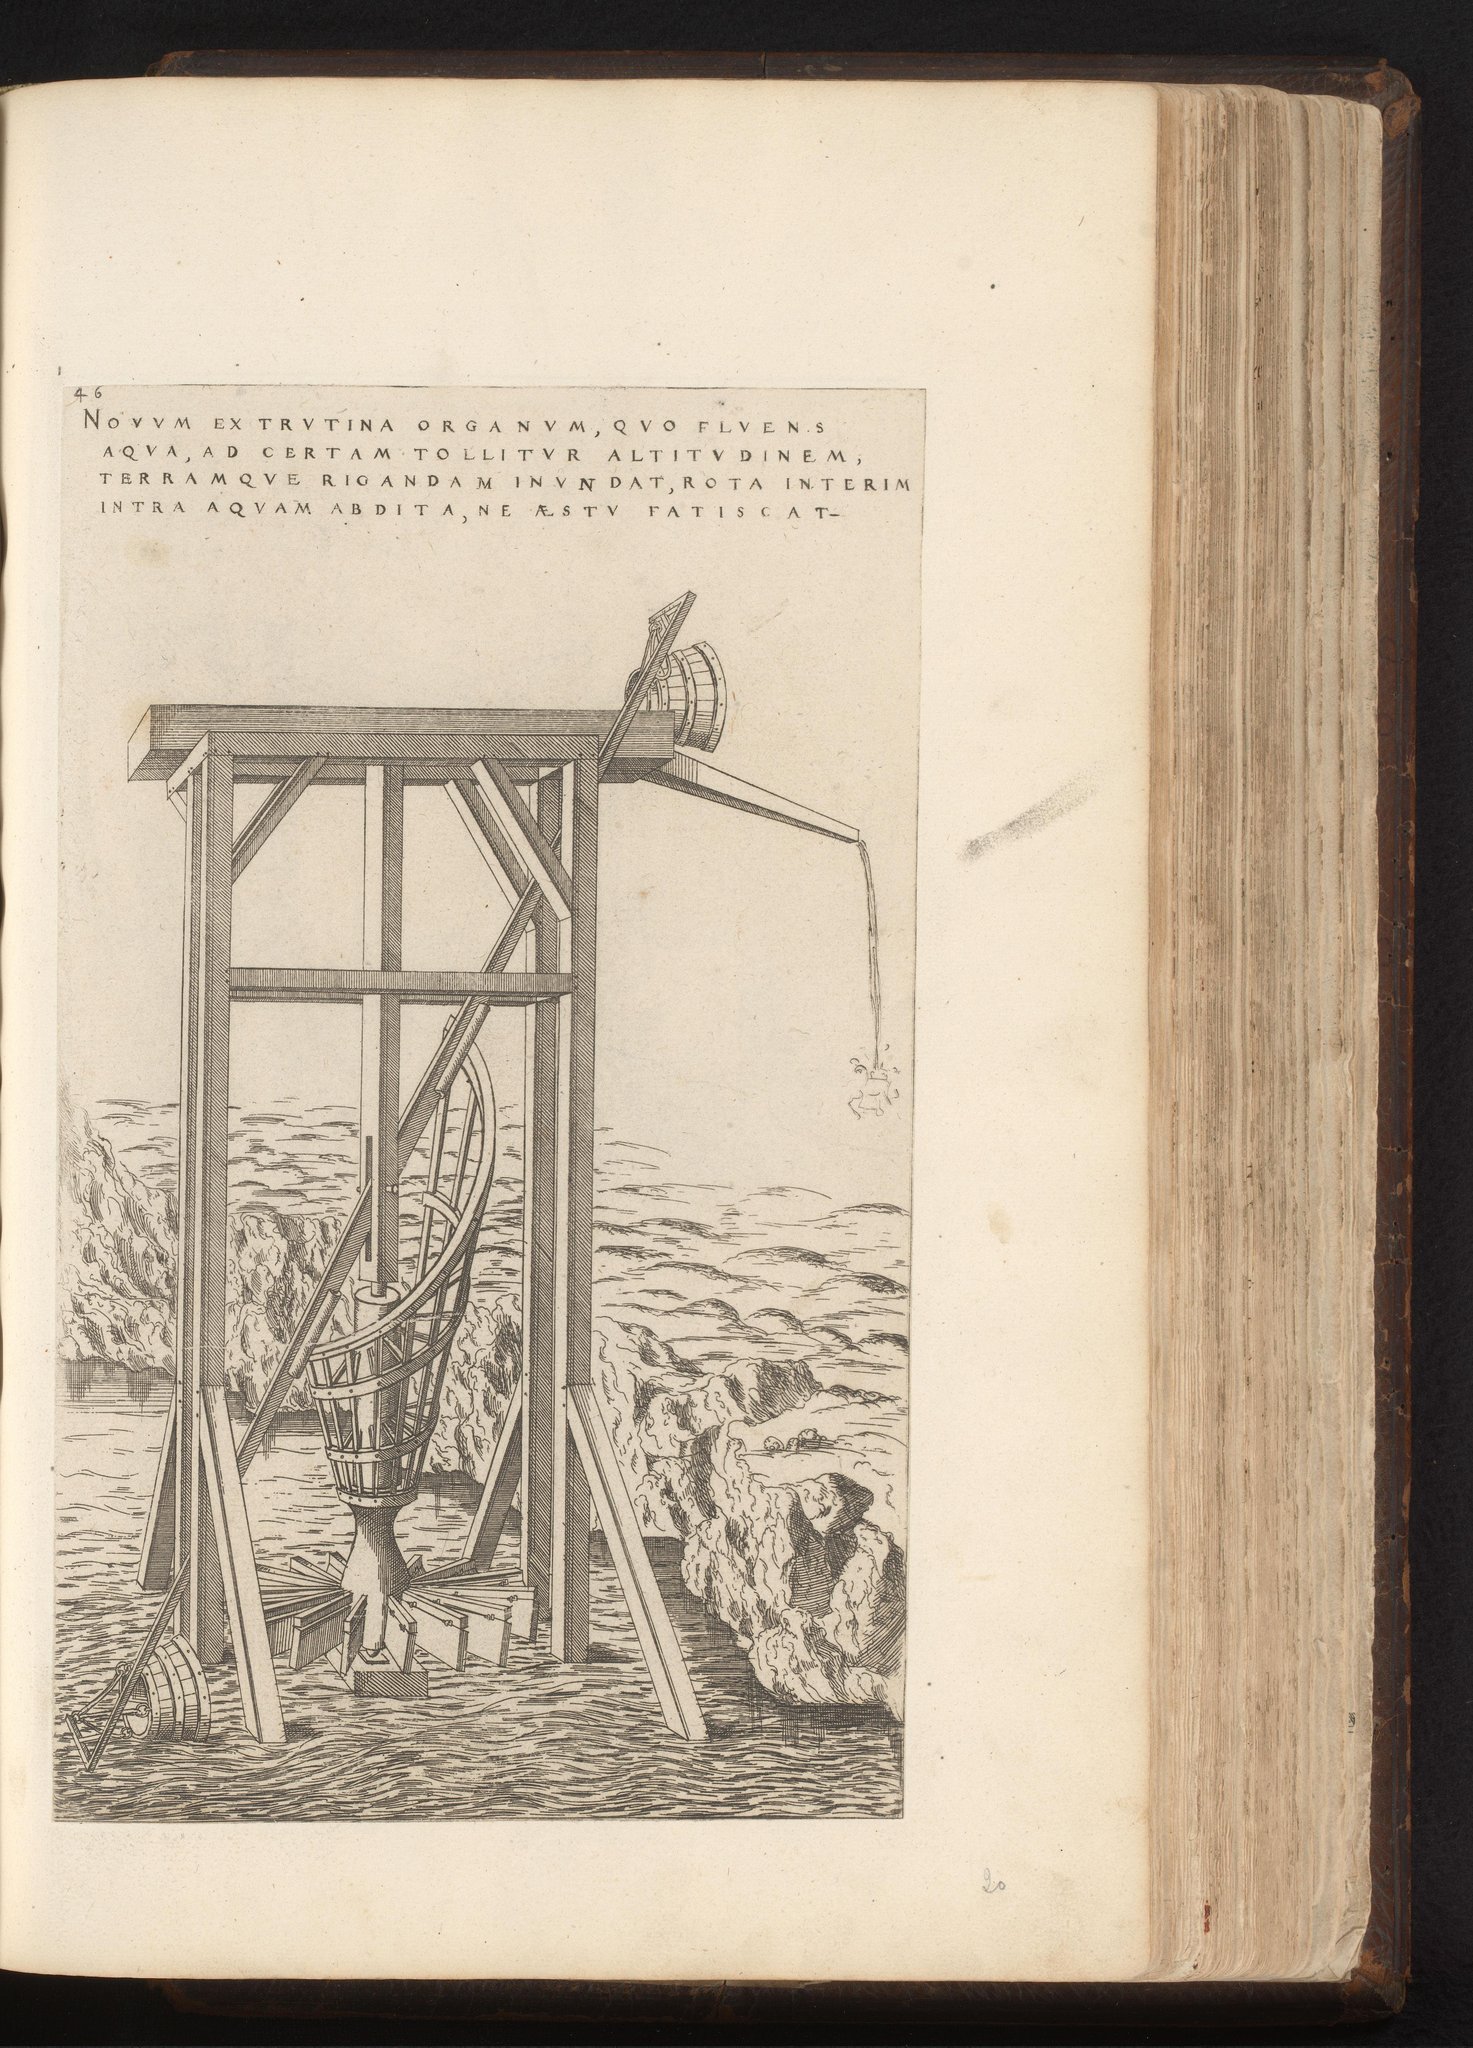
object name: book illustration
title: Houten irrigatiewerk in een meer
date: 1579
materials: paper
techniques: etching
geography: lyon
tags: irrigation ~ cultivation, invention, discovery ~ science and technology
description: Prent uit: Besson, Jacques. Theatre des instrumens mathematiques & mechaniques. Lyon: Barthelemy Vincent, 1579. Prent voor het eerst verschenen in de eerste editie van ca. 1569.